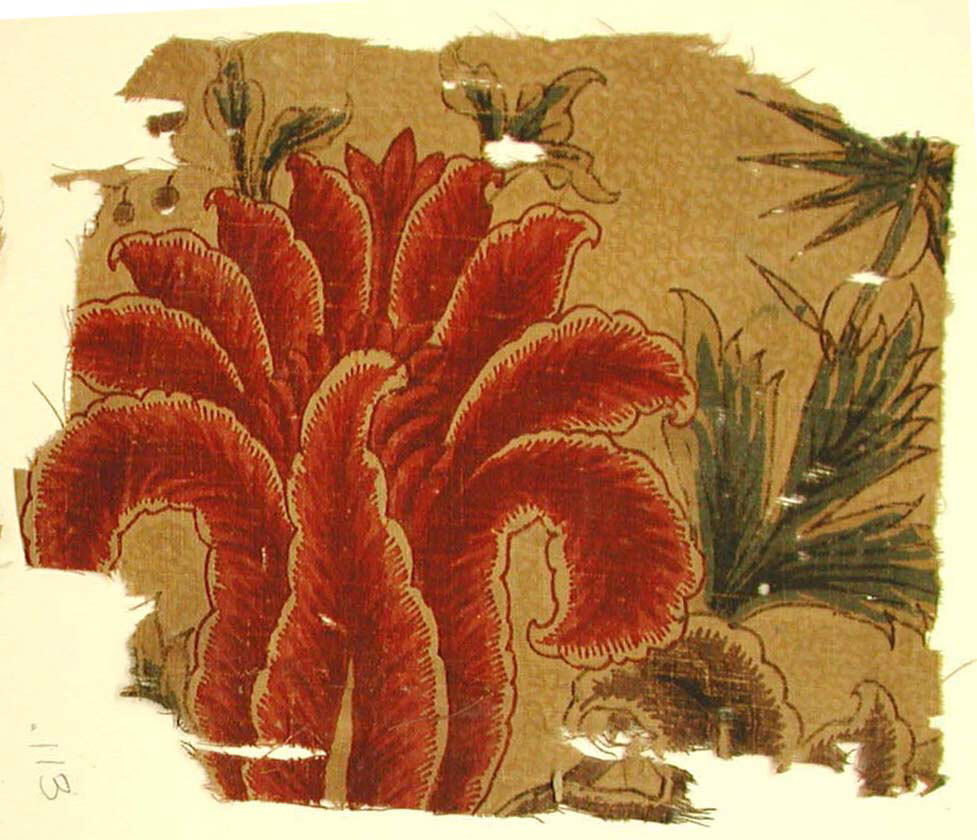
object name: fragment of a veil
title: Fragment of a Veil (Yashmak)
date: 1701-1800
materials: cotton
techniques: painting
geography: india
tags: flowers